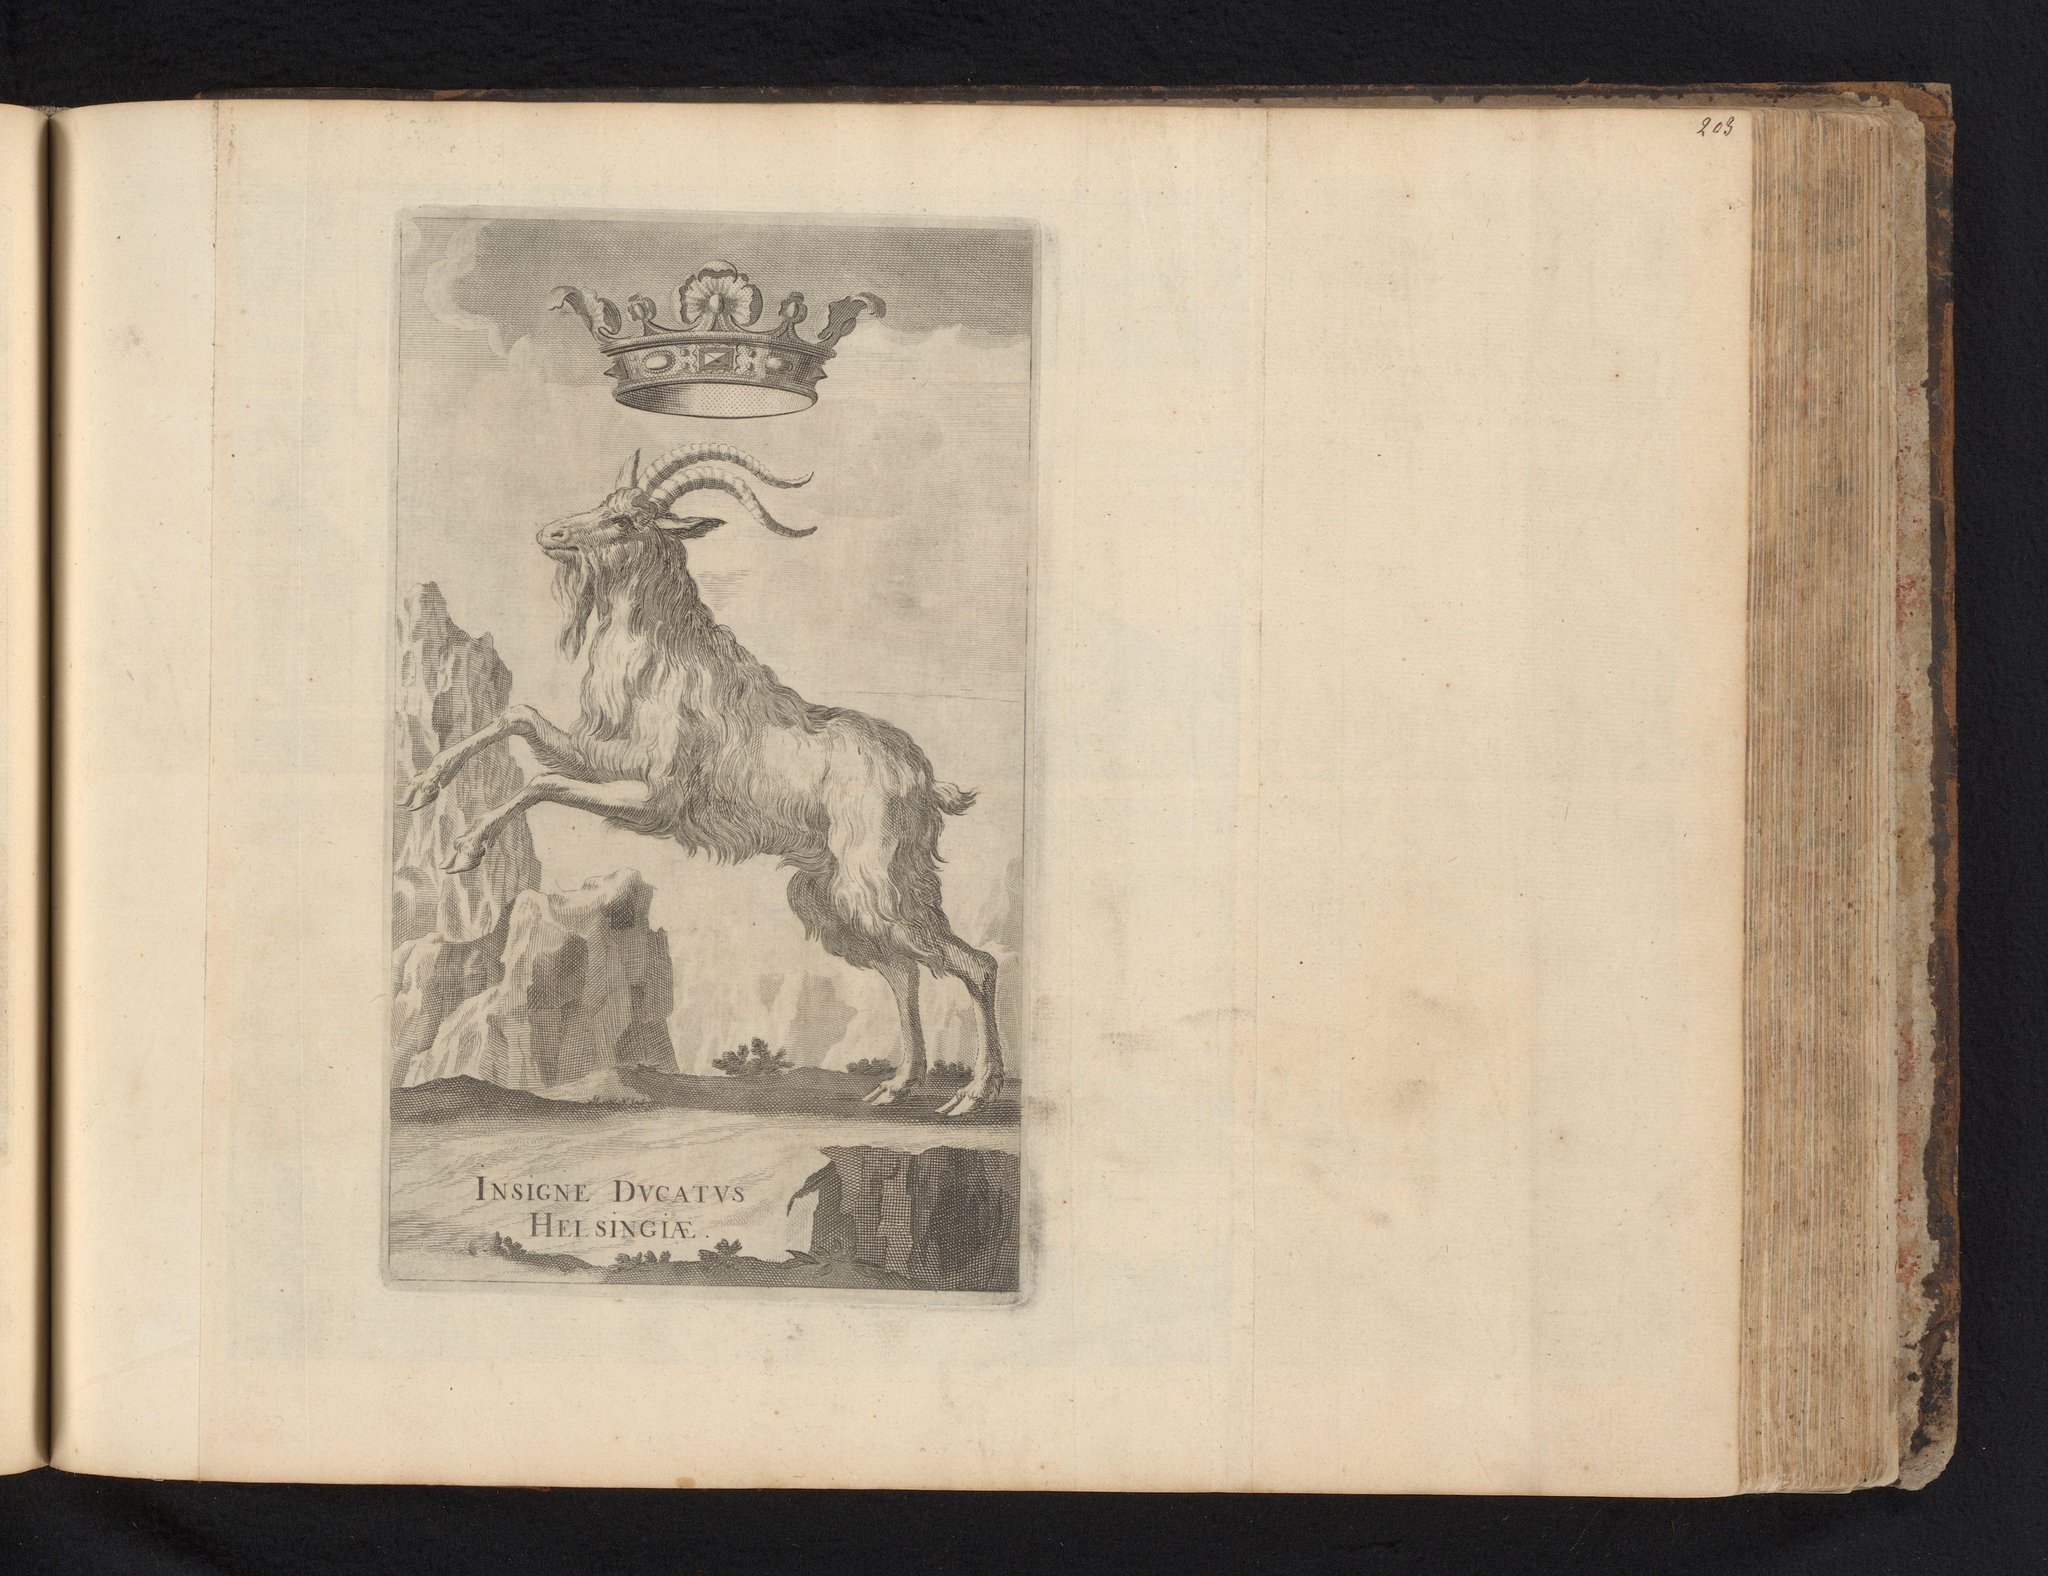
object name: print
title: Suecia Antiqua et Hodierna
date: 1696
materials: paper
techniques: etching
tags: coat of arms (as symbol of the state, etc.)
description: Kungliga Biblioteket, 'Suecia': http://www.kb.se/samlingarna/Kartor-bilder/Suecia-antiqua/ (geraadpleegd november 2016).